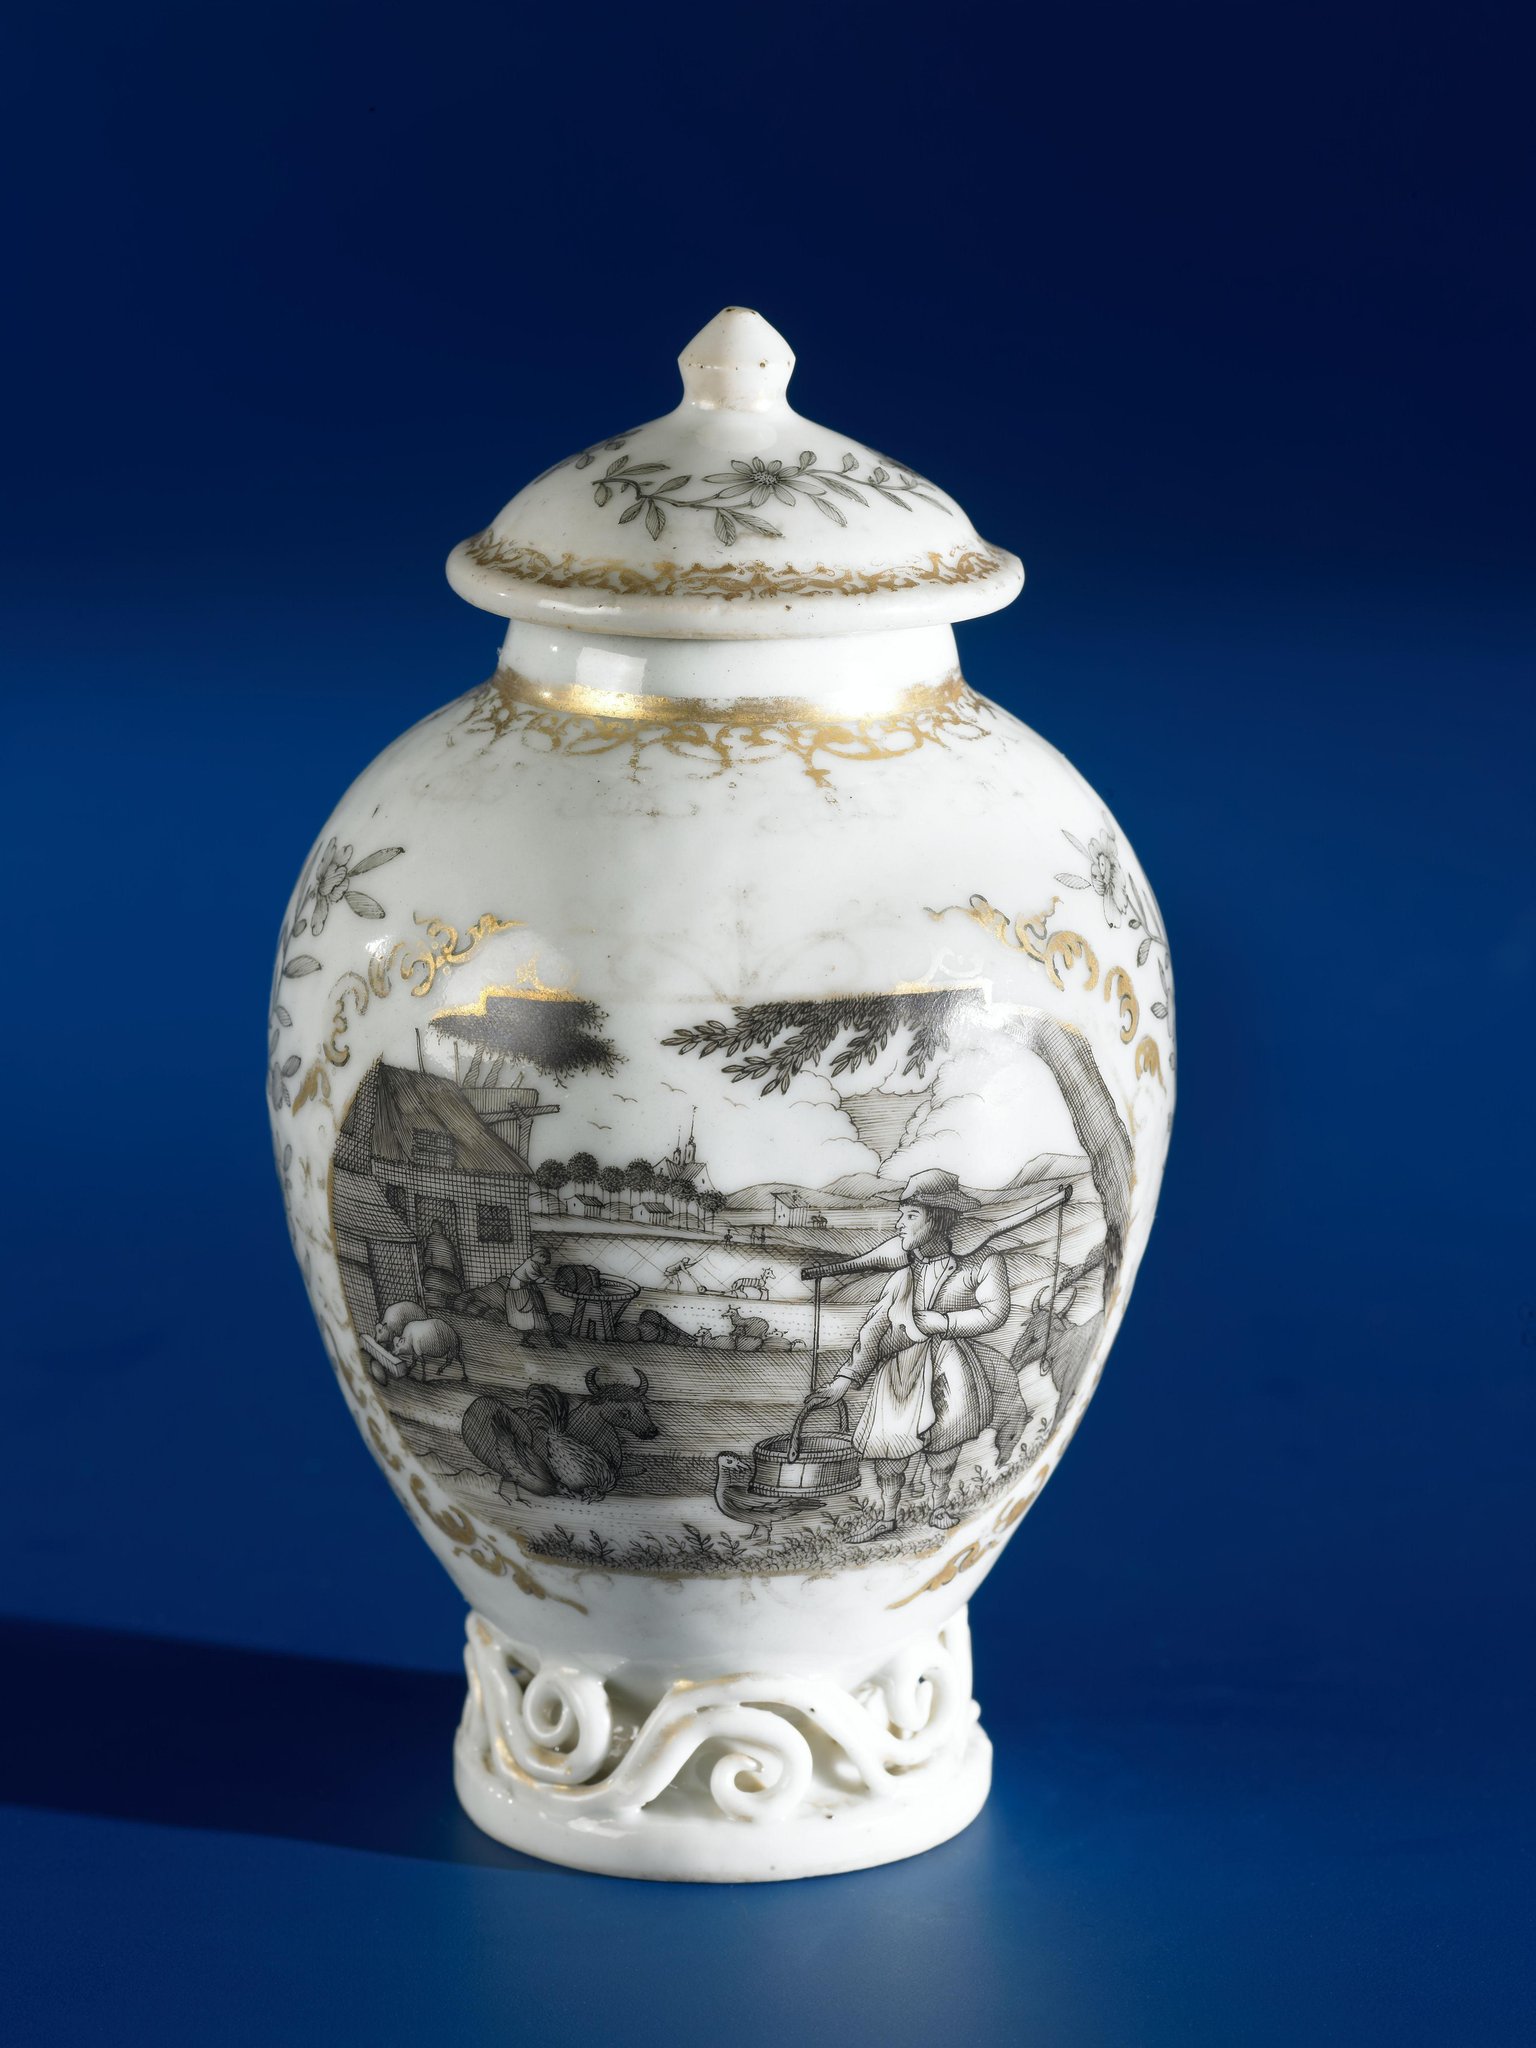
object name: lid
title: Ovoid tea caddy with a European country scene in two panels with flower sprays in between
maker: Anonymous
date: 1725-1749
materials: glaze, gold, paint, porcelain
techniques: firing, forming, gilding, turning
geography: china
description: Hoge eivormige pot op een hoge, opengewerkte voet. Klokvormige deksel met knop. Gedecoreerd in encre de Chine en goud met een gedetailleerd landschappelijk tafereel. Op de voorgrond een boerenjongen met een juk met emmer op zijn schouders. Verschillende dieren zijn afgebeeld zoals koeien, schapen en kippen. Op de achtergrond een boerderij, een dorp met kerktoren en verschillende mensen die op het land werken.